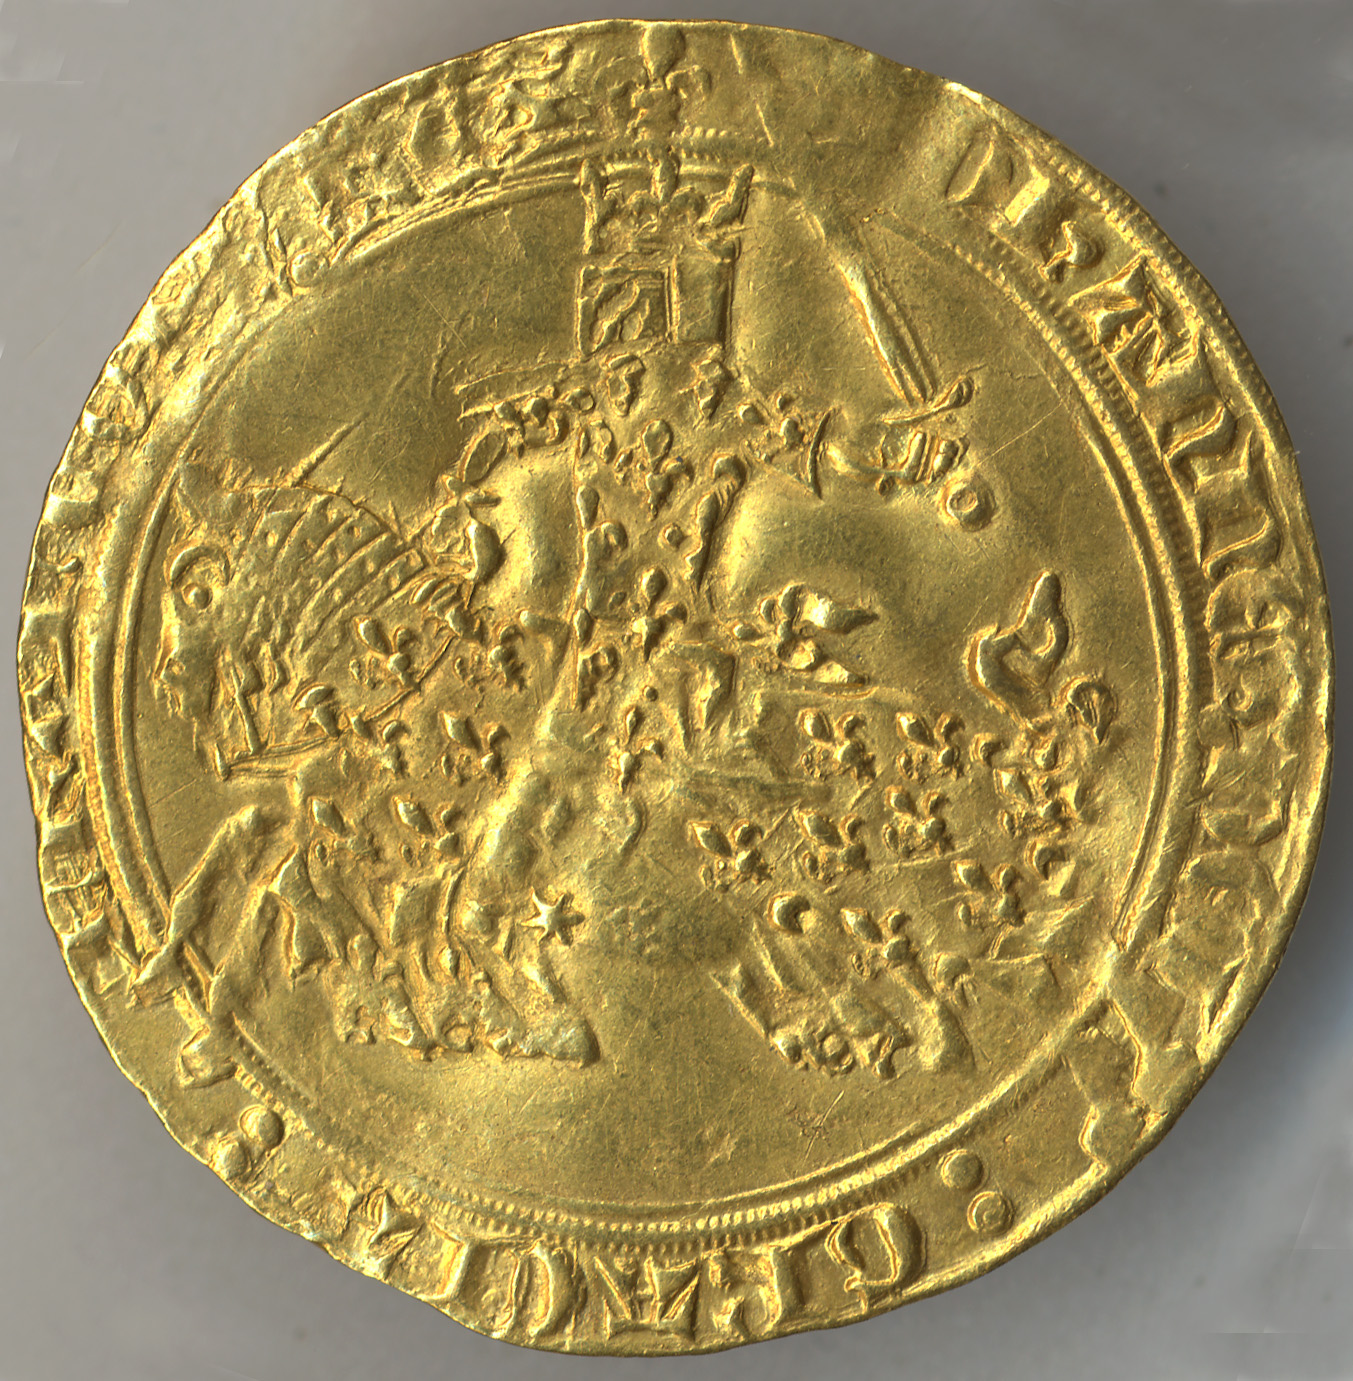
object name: coin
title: Franc à Cheval of John the Good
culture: french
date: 1350-1364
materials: gold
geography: france